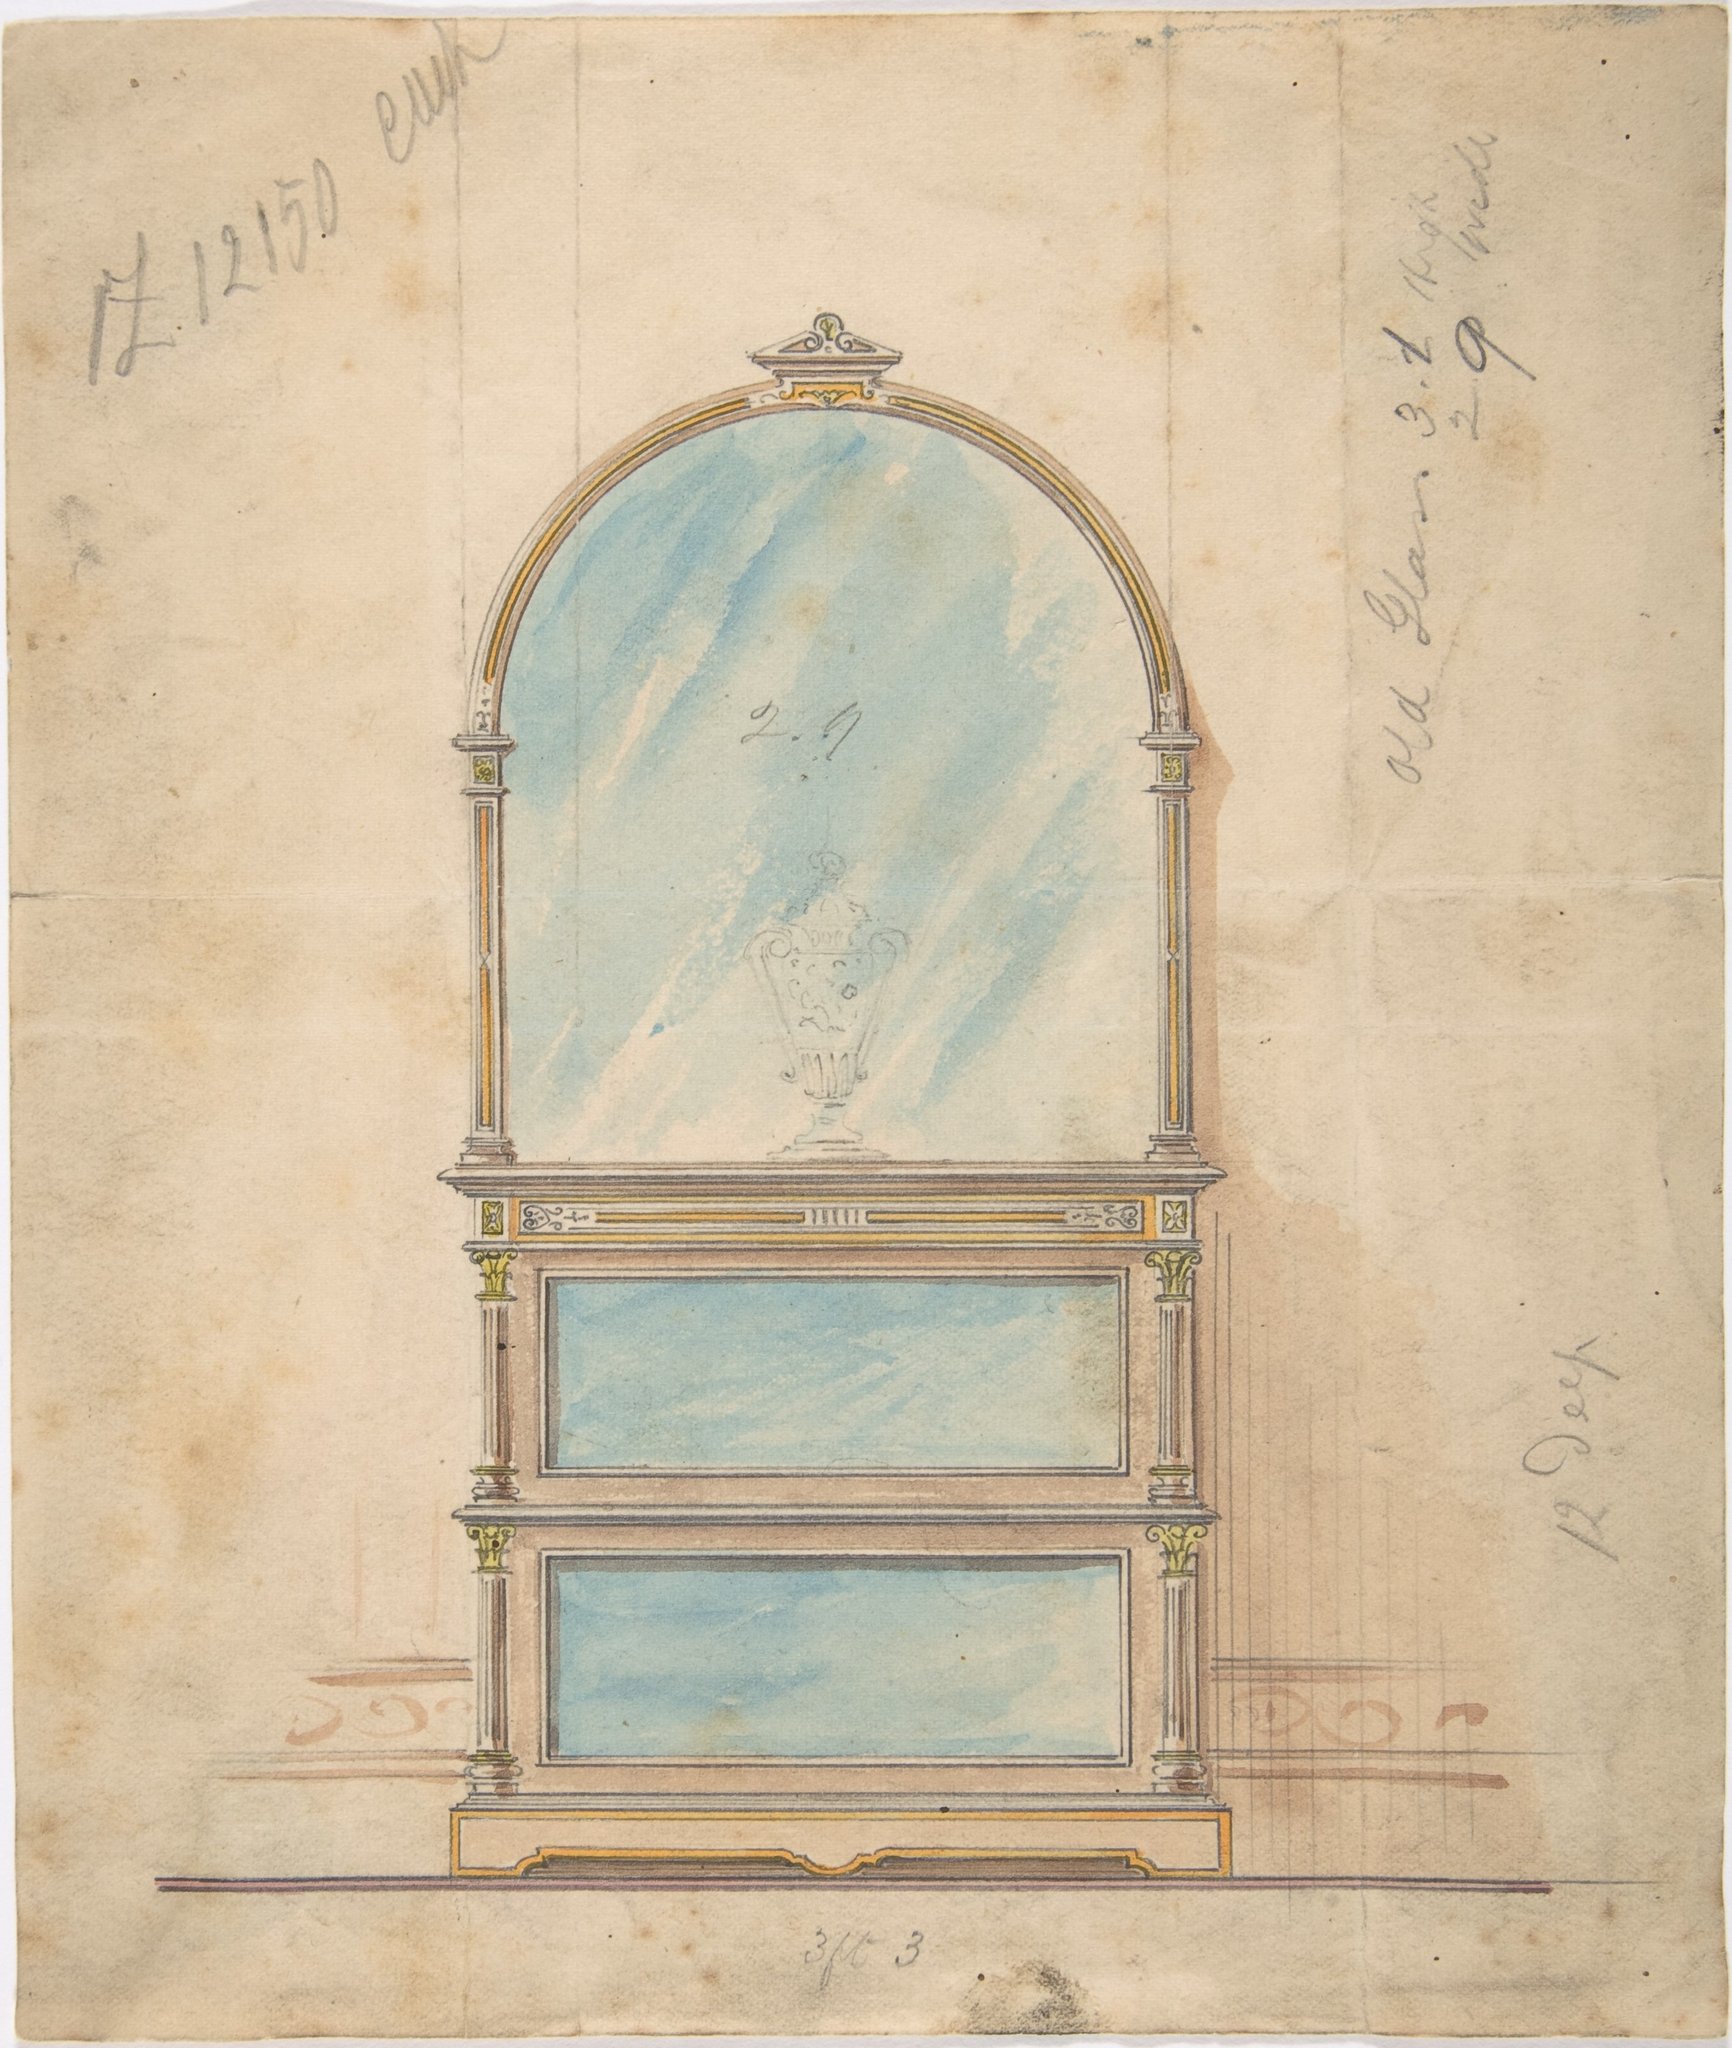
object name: drawing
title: Design for a Mirror-fronted Cabinet Topped with a Mirror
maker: anonymous, british, 19th century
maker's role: artist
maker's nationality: british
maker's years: 1800-1900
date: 1801-1900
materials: ink, watercolor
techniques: pen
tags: cabinets,mirrors